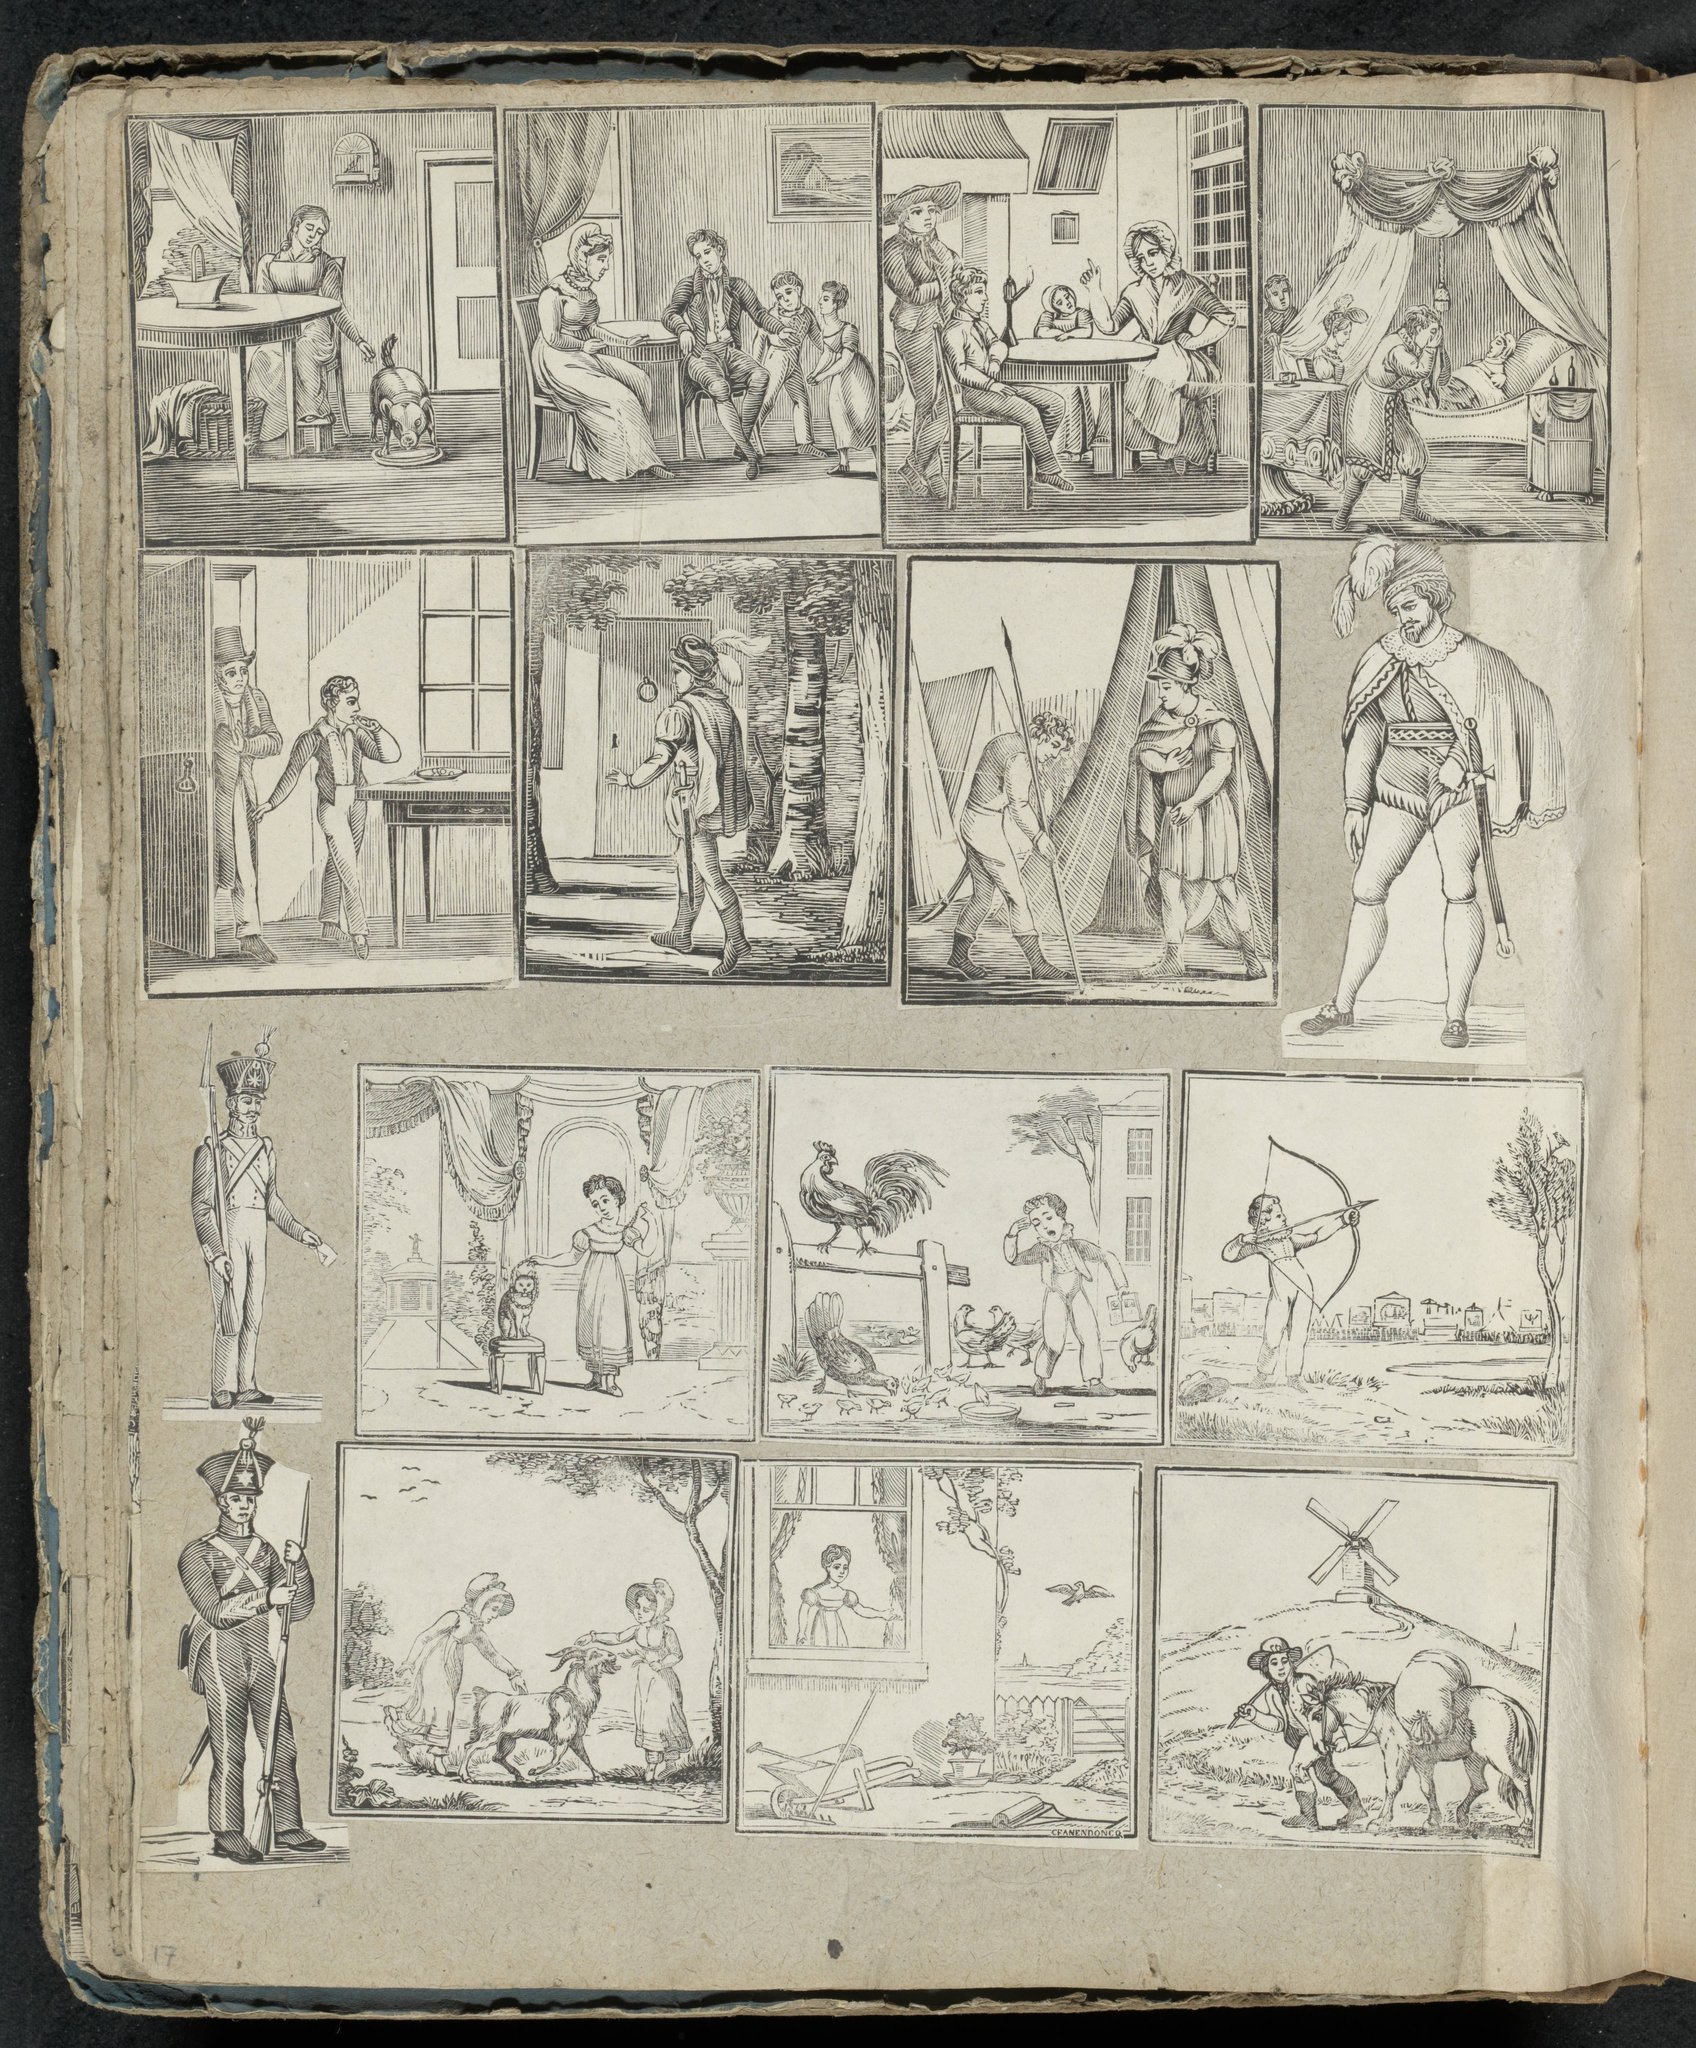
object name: print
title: Albumblad met diverse voorstellingen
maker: alexander cranendoncq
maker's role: draughtsman, print maker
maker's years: 1799-1869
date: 1814-1869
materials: paper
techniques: snipping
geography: nijmegen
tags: children's games and plays, family, relationship, descent, child playing with animals, the soldier; the soldier's life, shooting with bow and arrow, archery (~ games of skill), children (first degree family relationships), parents (first degree family relationships)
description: Albumblad met 16 uitgeknipte voorstellingen uit voornamelijk volksprenten, onder andere van militairen, spelende kinderen en gezinnen.